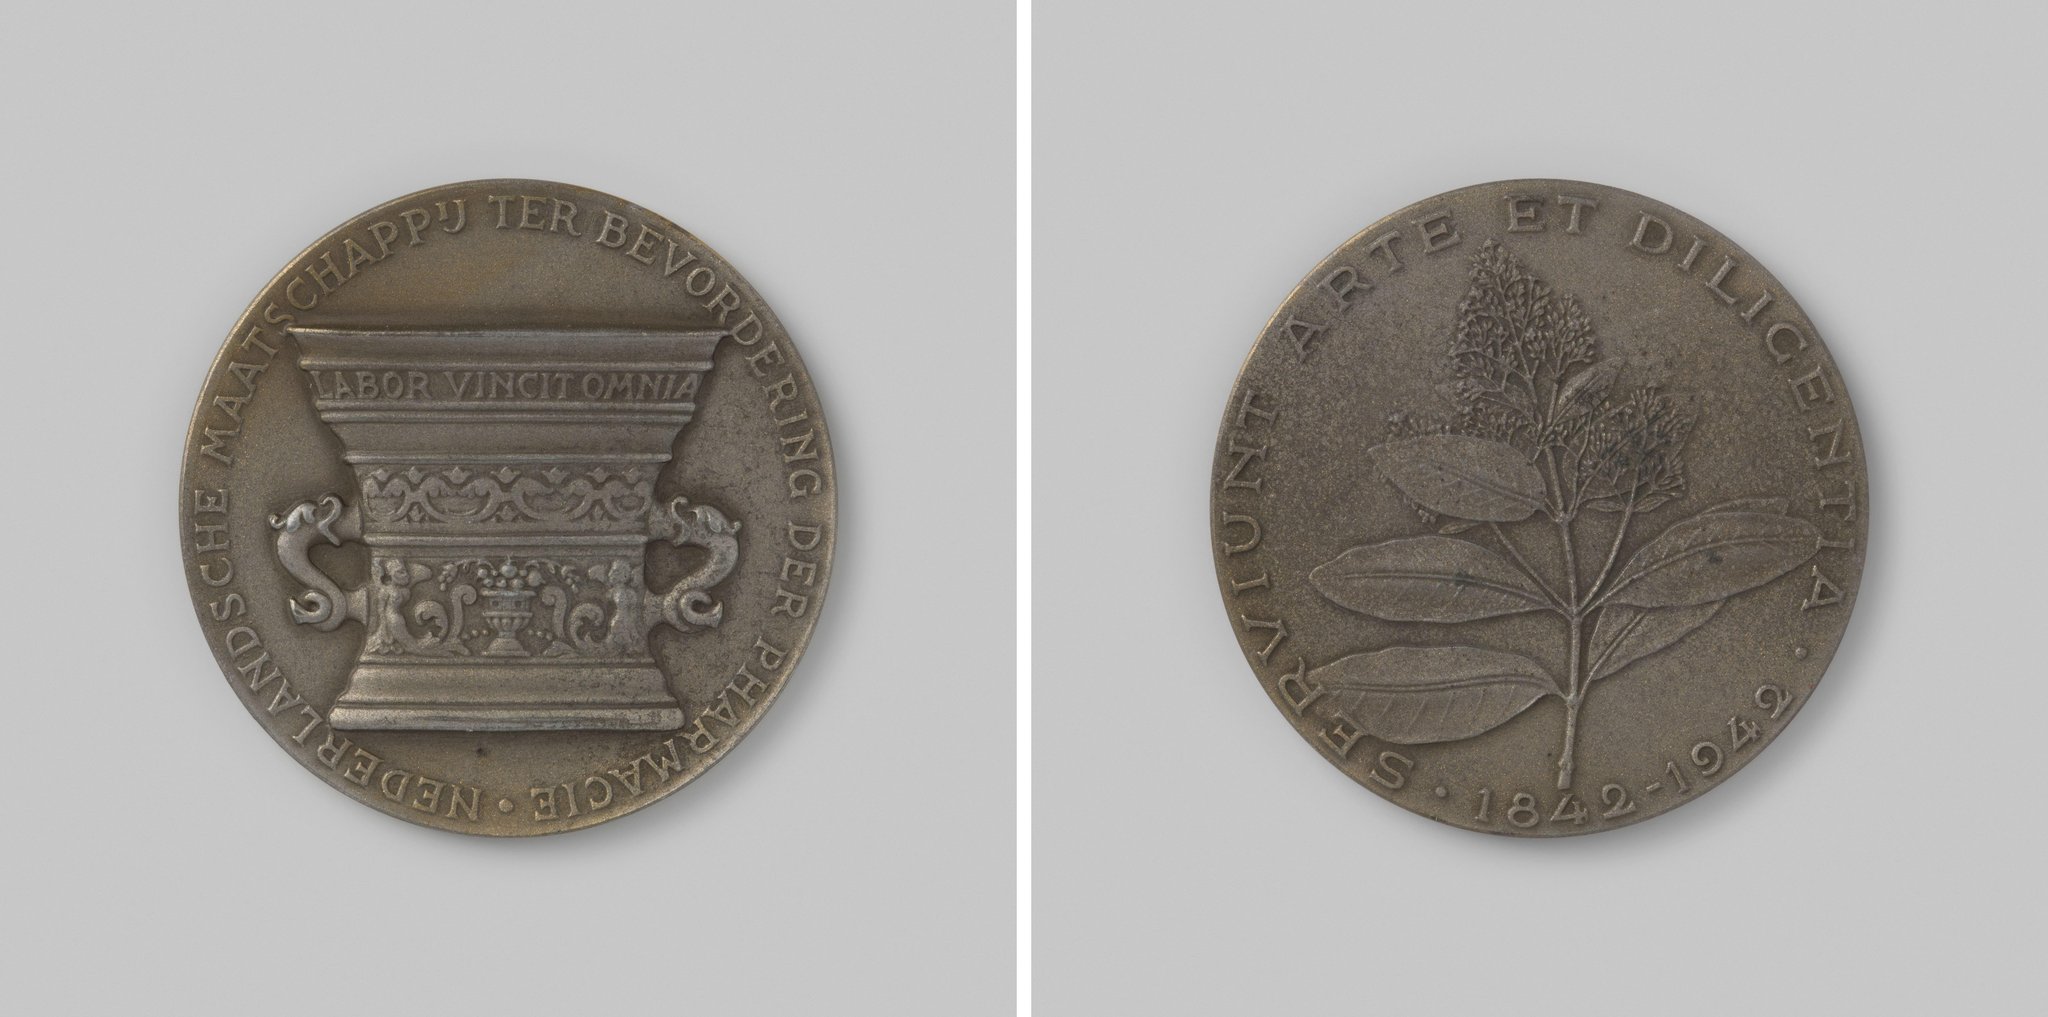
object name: history medal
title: 100-Jarig bestaan der Nederlandsche Maatschappij tot bevordering der pharmacie 1842 - 1942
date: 1942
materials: copper, zinc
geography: voorschoten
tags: koninklijke nederlandse maatschappij ter bevordering der pharmacie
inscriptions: inscription: ‘LABOR VINCIT OMNIA’, circumscription: ‘NEDERLANDSCHE MAATSCHAPPIJ TER BEVORDERING DER PHARMACIE’, circumscription: ‘SERVIUNT ARTE ET DILICENTIA 1842 - 1942’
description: Penning bestaande uit een legering van zink en koper. Voorzijde: antieke vijzel met omschrift. Keerzijde: de tak van Cinchona Ledgeriana Javanensis met omschrift. In rond wit doosje waarin beschrijving. Aangeboden door de Nederlandsche Apothekerskamer ter herinnering aan het vele goede, dat verricht is door de Nederlandsche Maatschappij tot bevordering der Pharmacie.